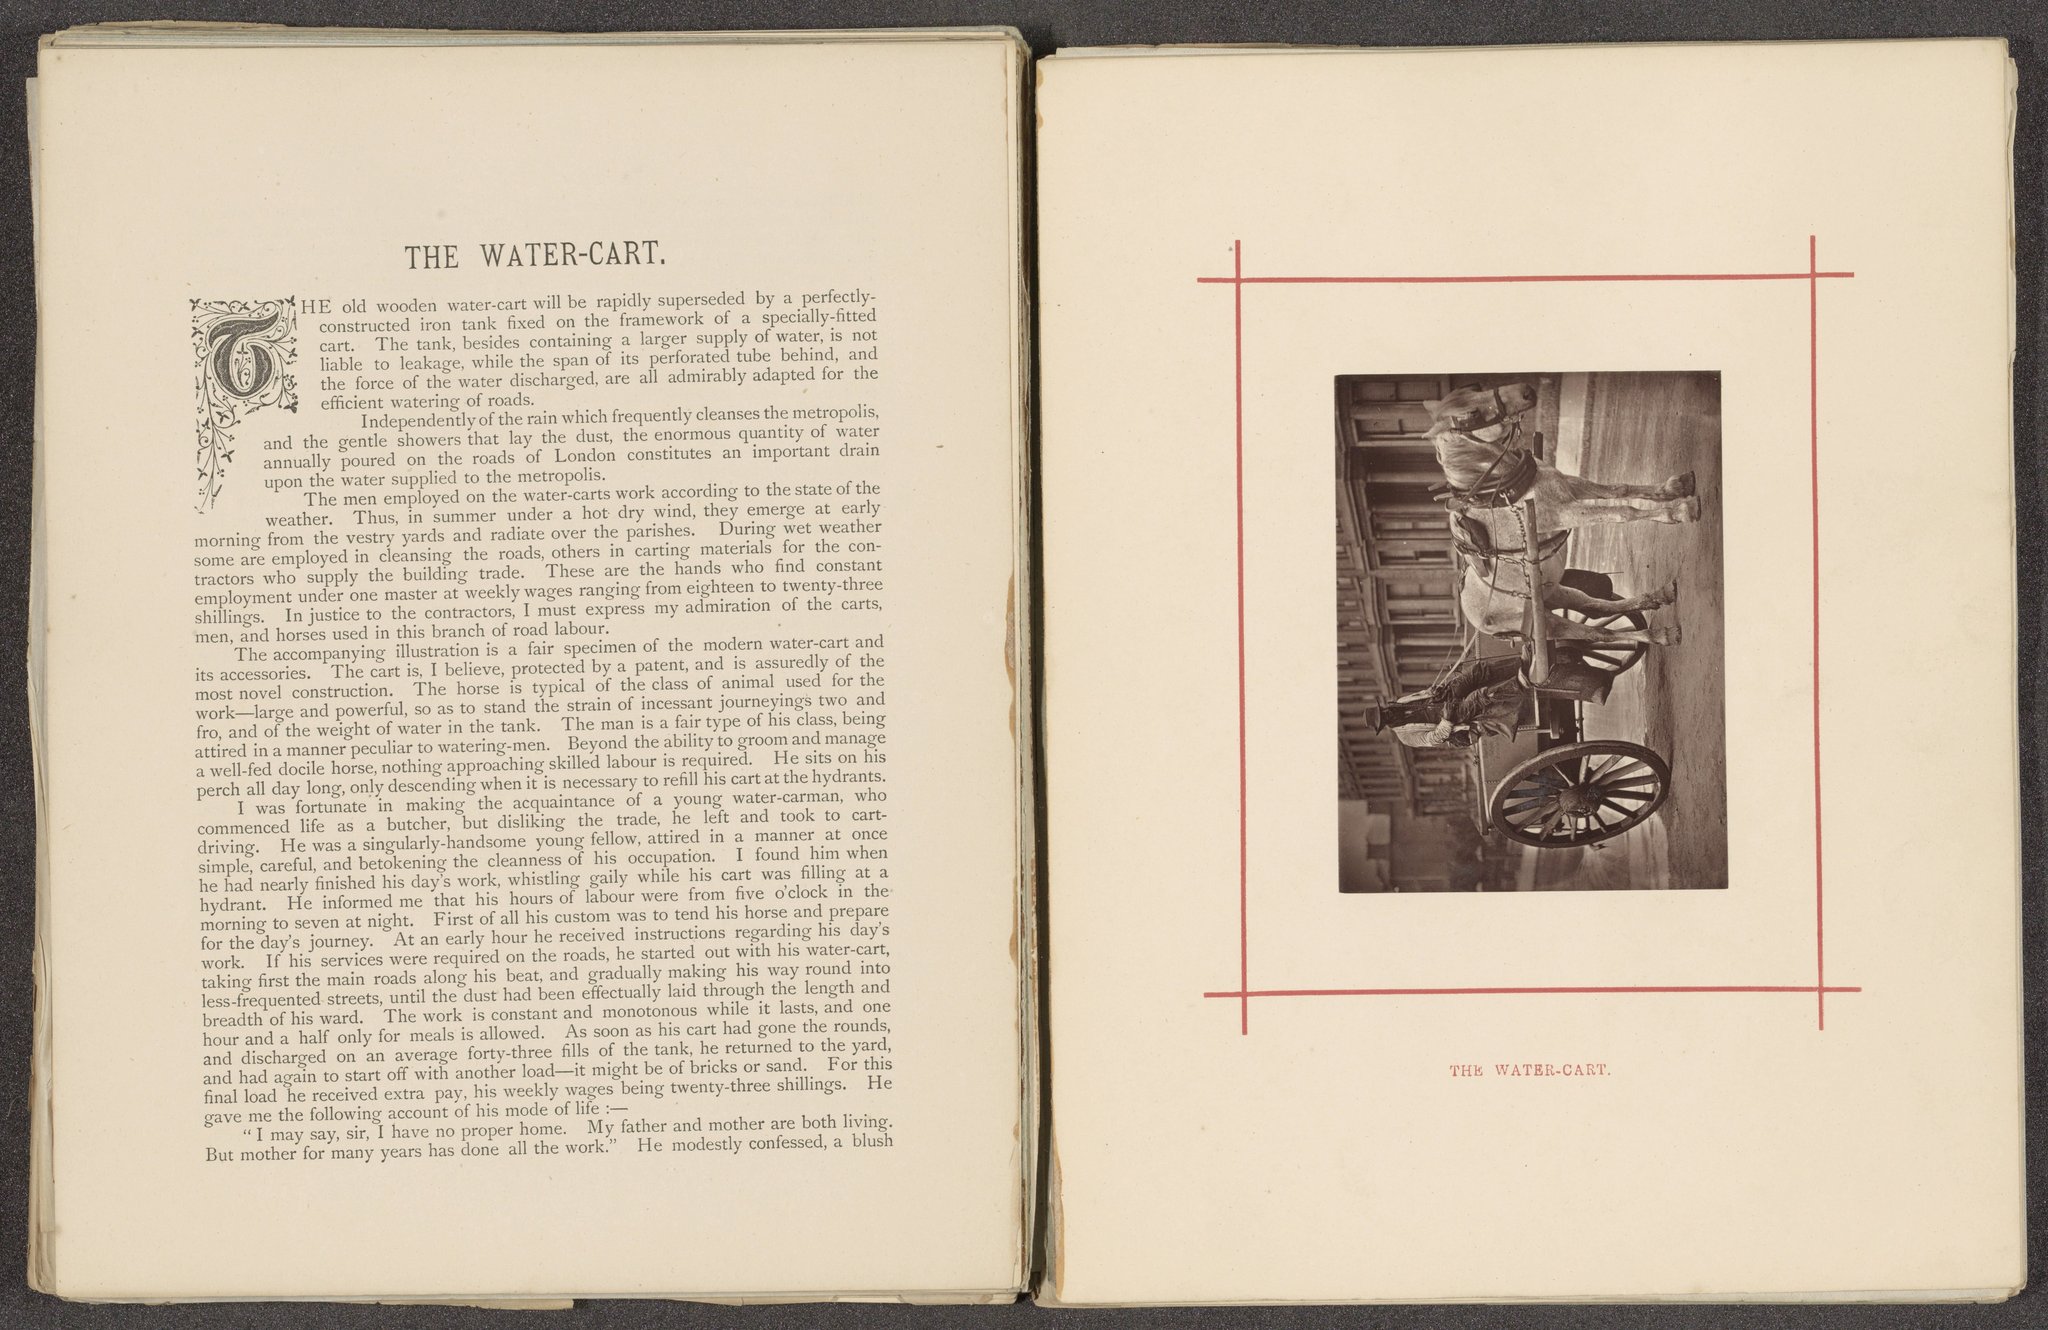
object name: photomechanical print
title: The water-cart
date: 1876-1877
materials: paper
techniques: woodburytype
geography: london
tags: two-wheeled, animal-drawn vehicle, (farm) wagon, freight wagon, cart, london